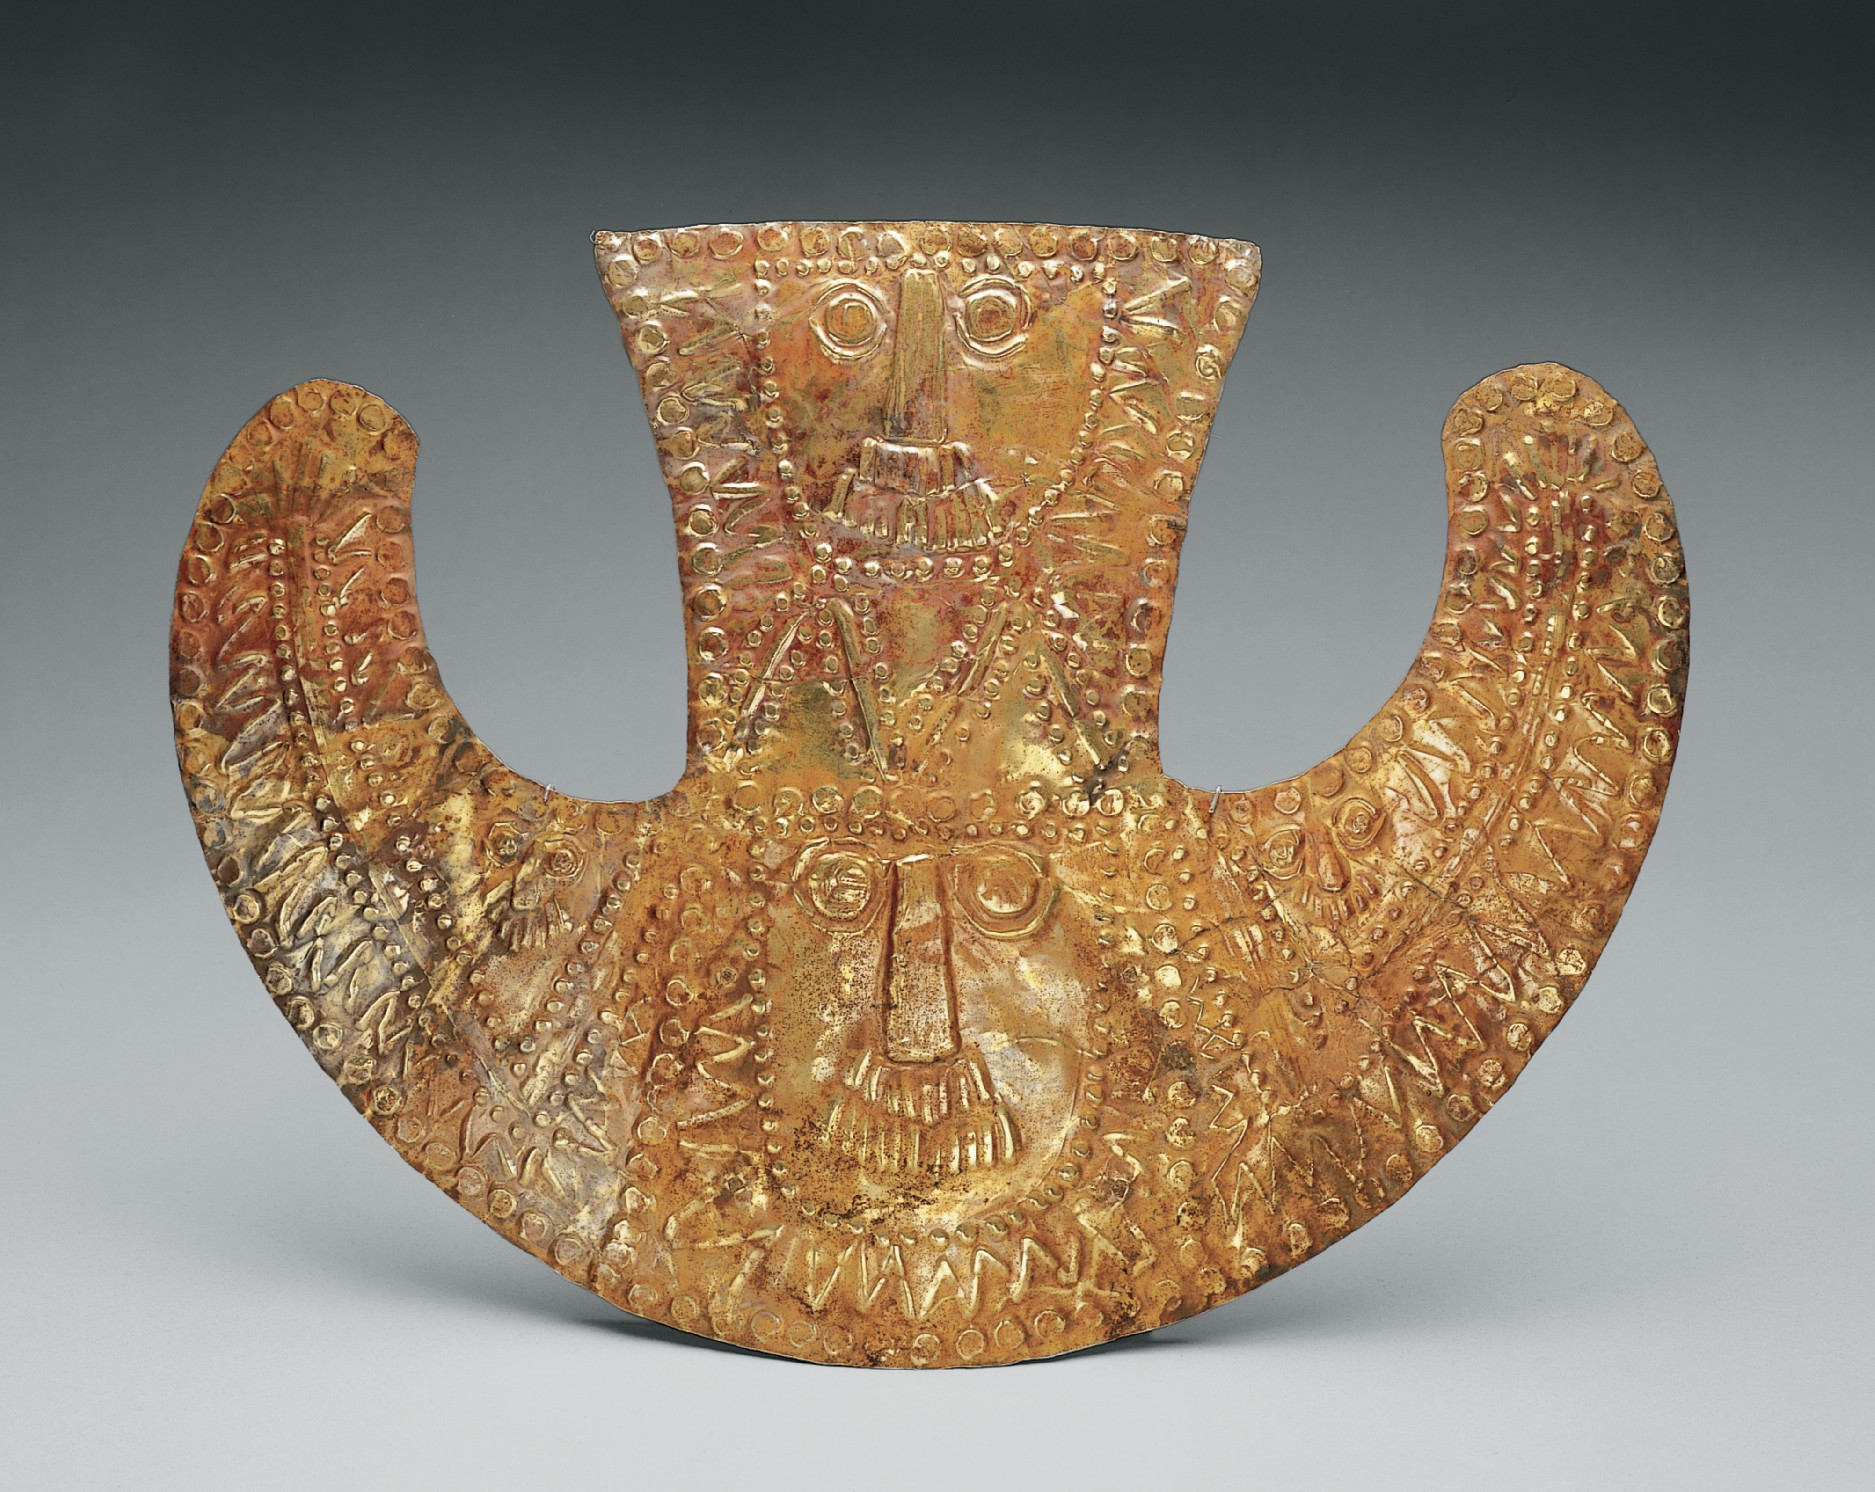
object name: ornament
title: Headdress Ornament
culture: siguas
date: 100 BCE-300 CE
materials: gold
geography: peru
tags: human figures